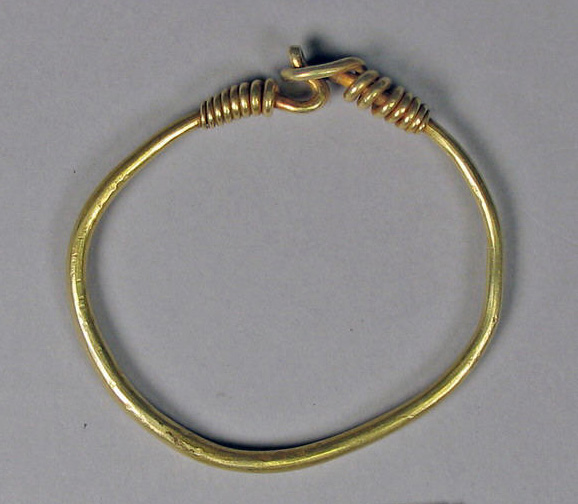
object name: bracelet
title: Bracelet with Twisted Wire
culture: indonesian, central java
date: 701-1200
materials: gold